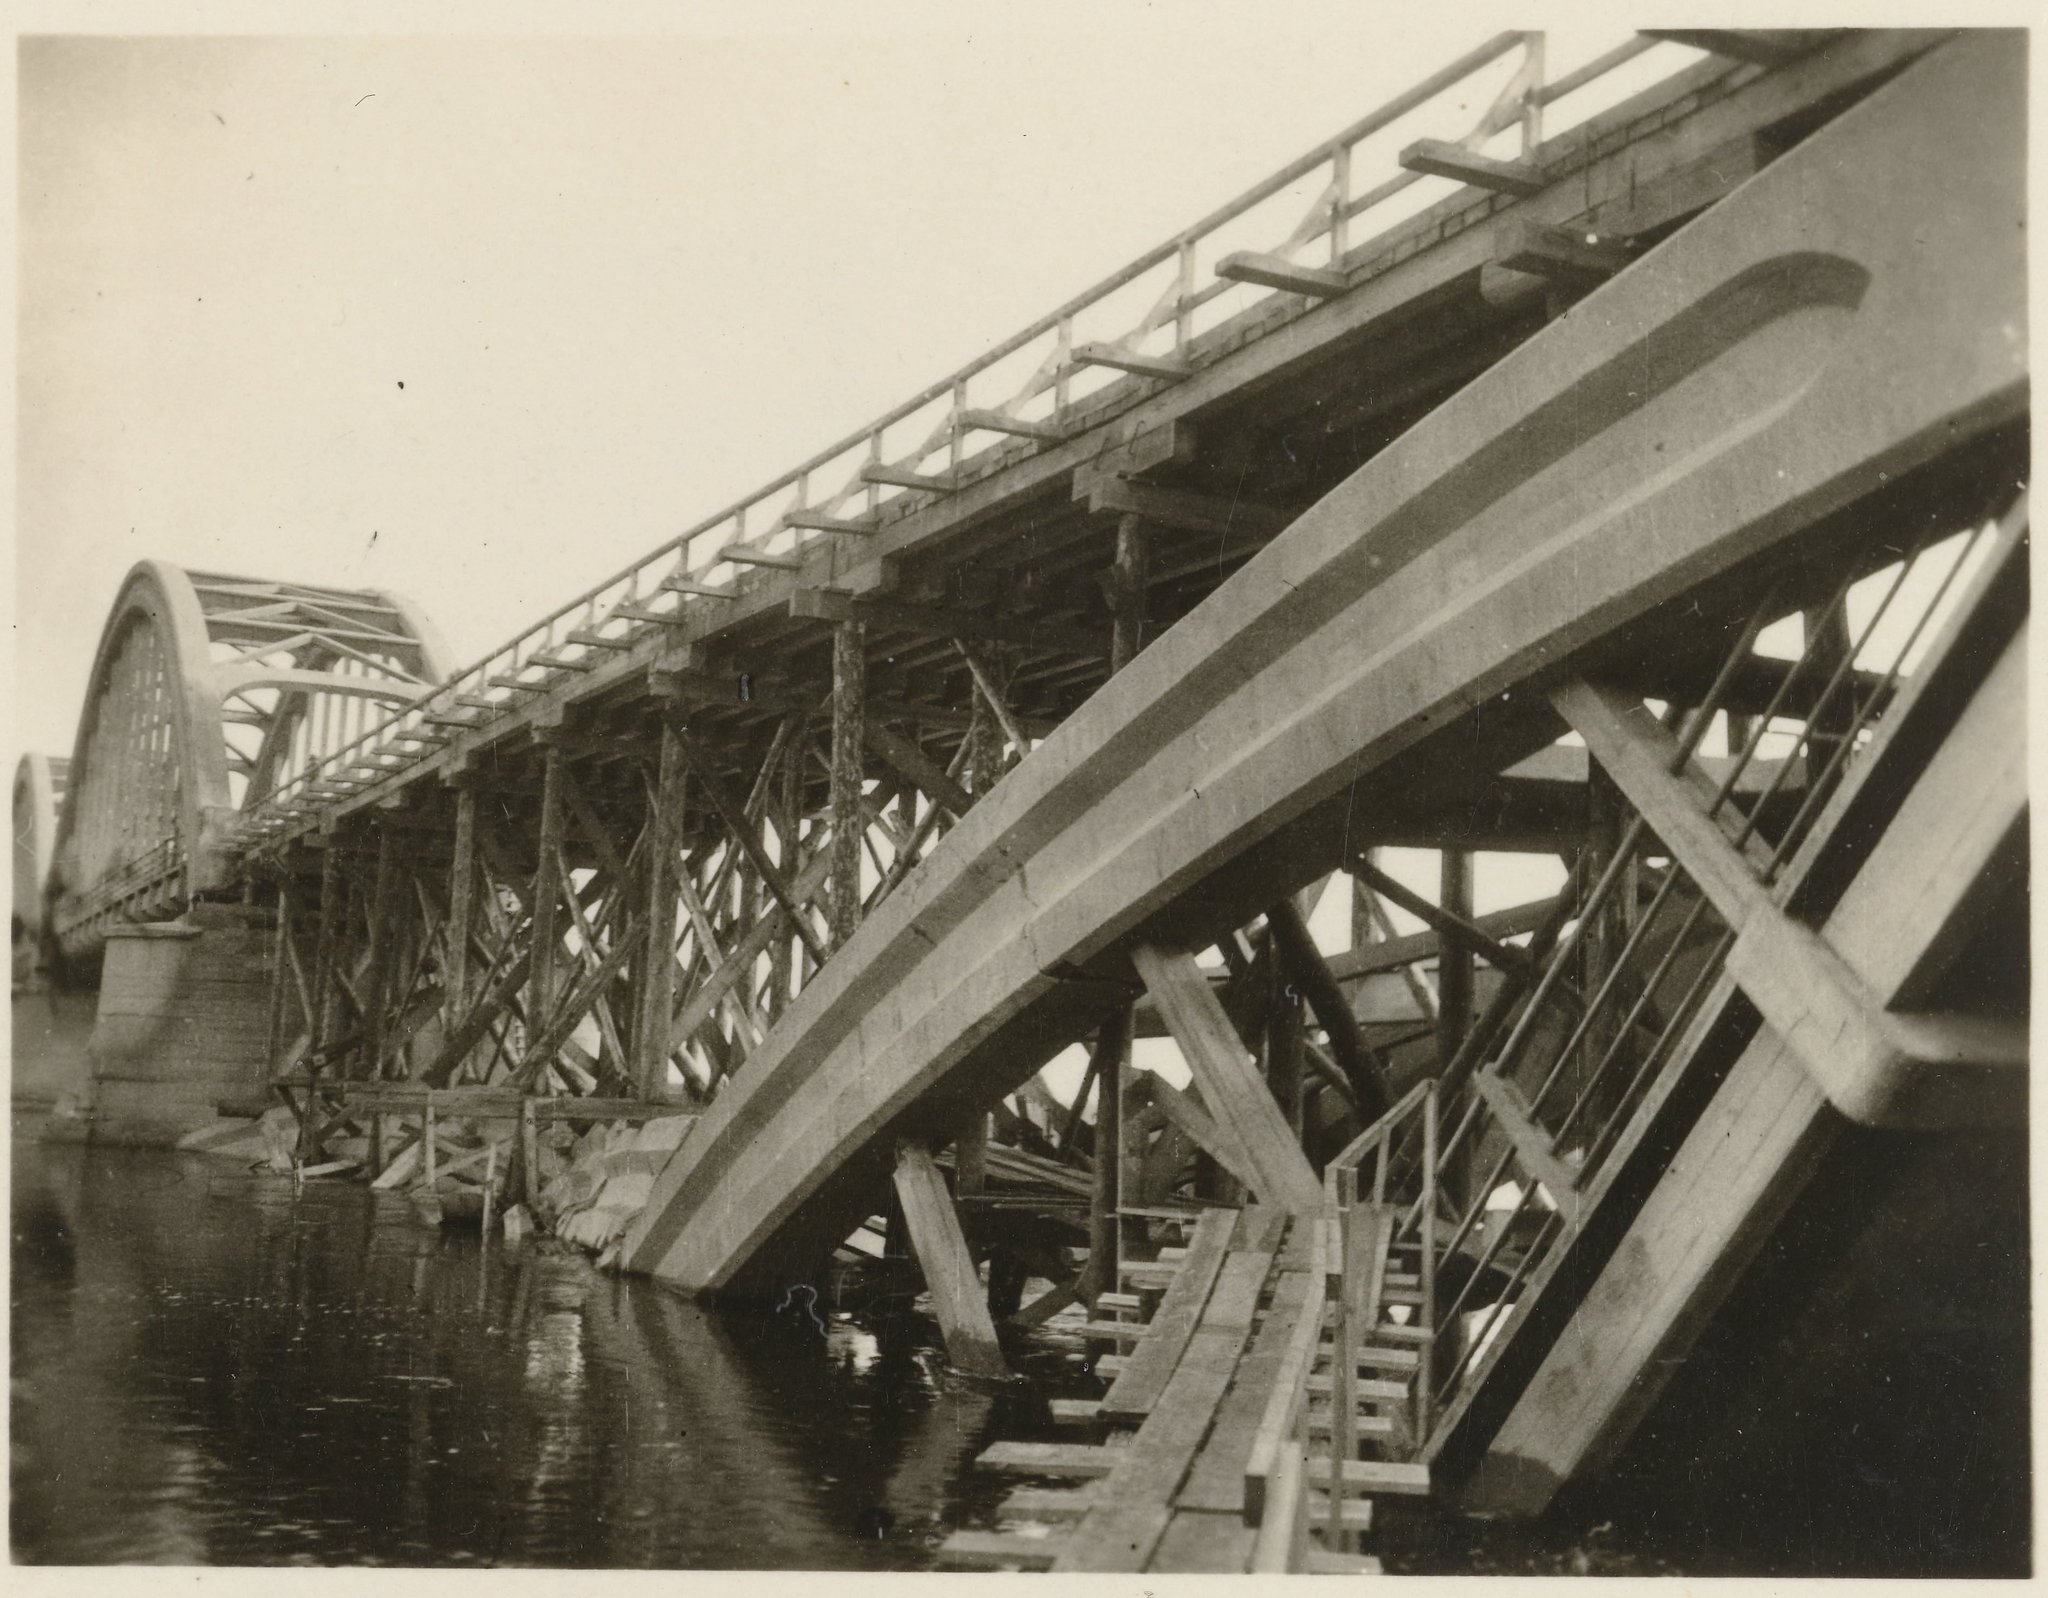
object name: photograph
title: Rijnbrug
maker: Anonymous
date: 1940-1945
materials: photographic support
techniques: gelatin silver print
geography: netherlands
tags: netherlands, germany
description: Brug over de Rijn. Foto behorend bij album 'Kriegserinnerungen'.